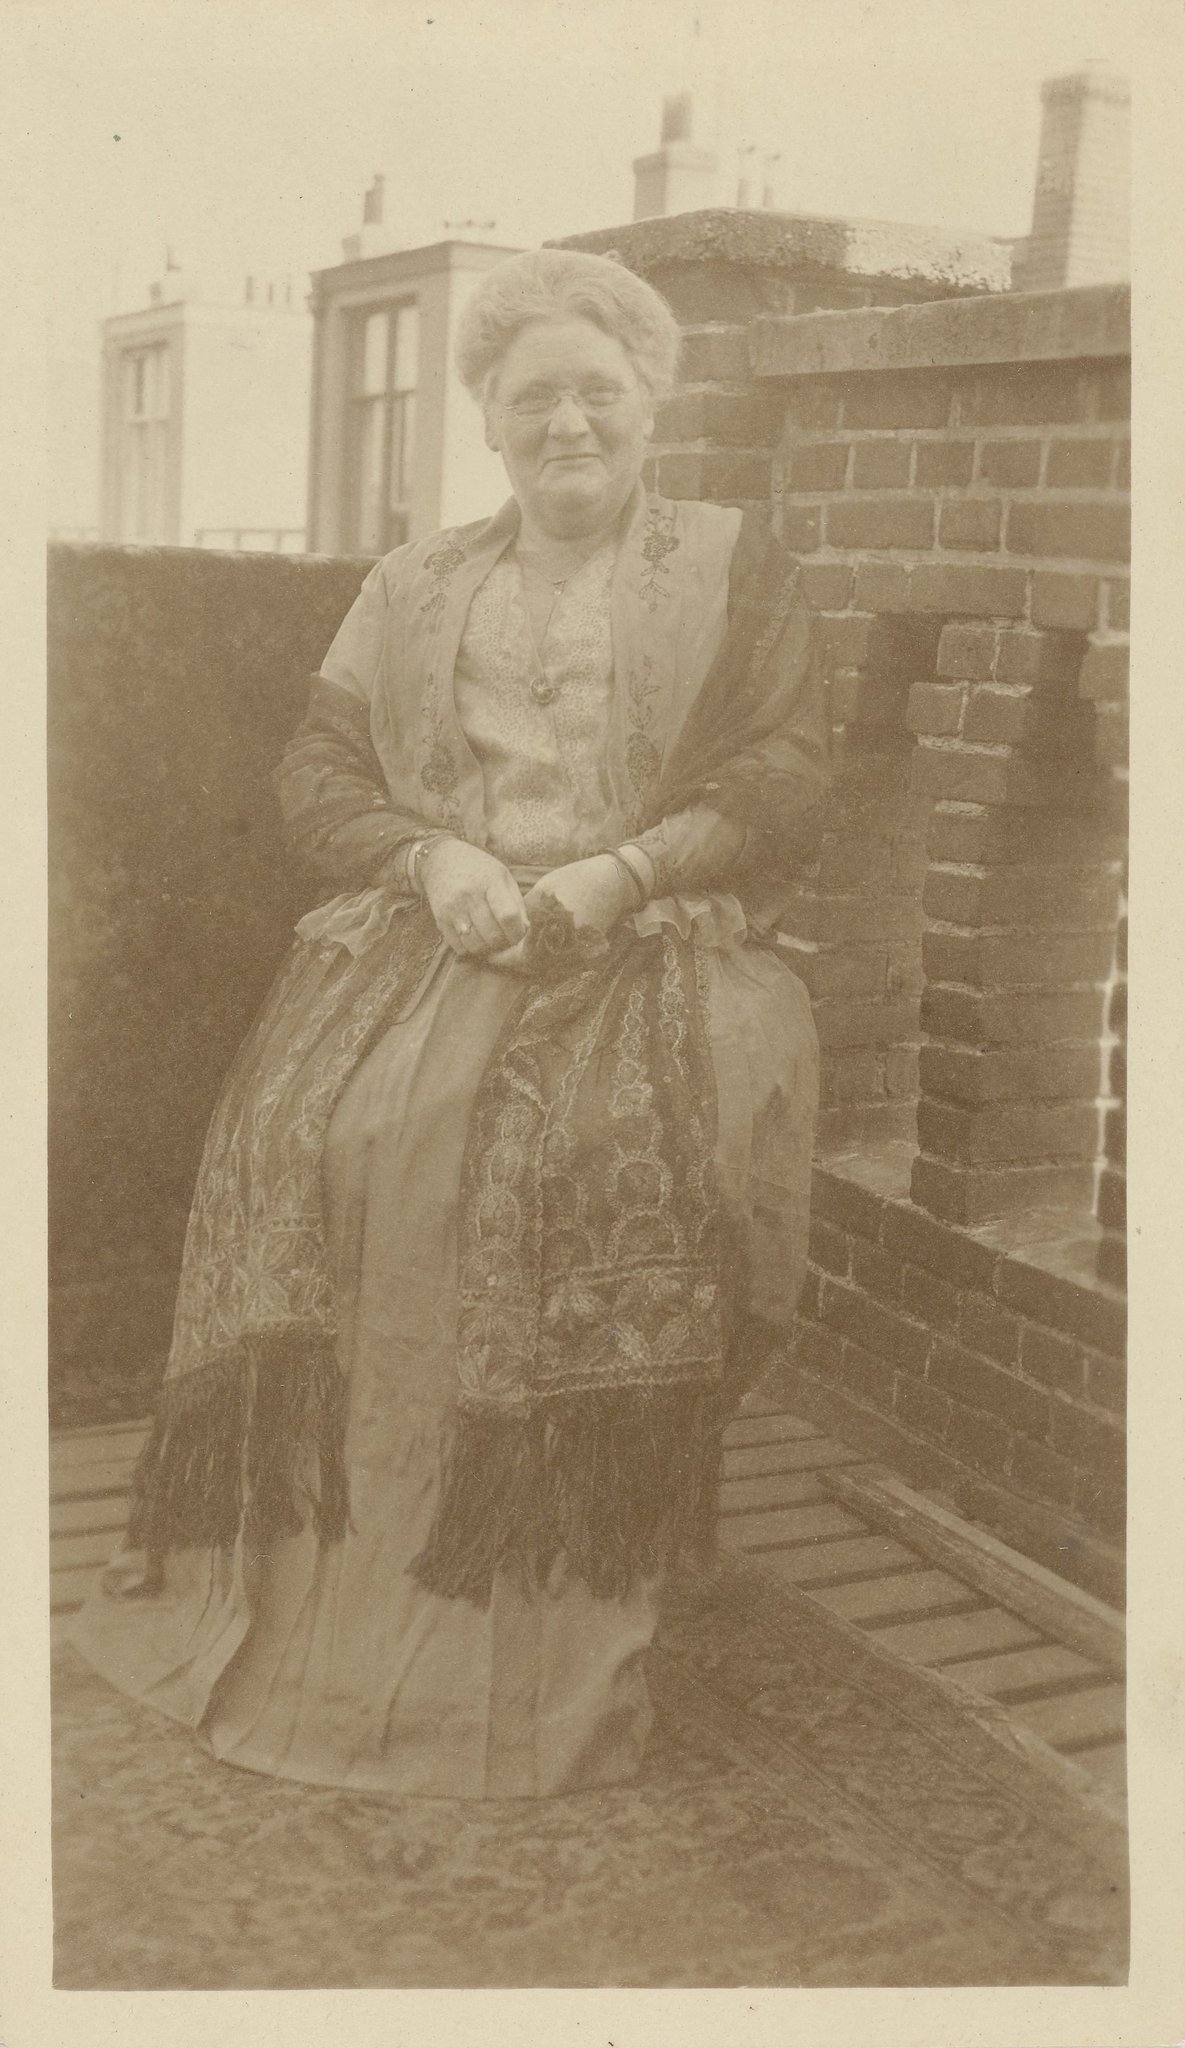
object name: photograph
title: Portret van Grietje Vermeulen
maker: Anonymous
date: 1925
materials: cardboard, photographic support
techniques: carbon print